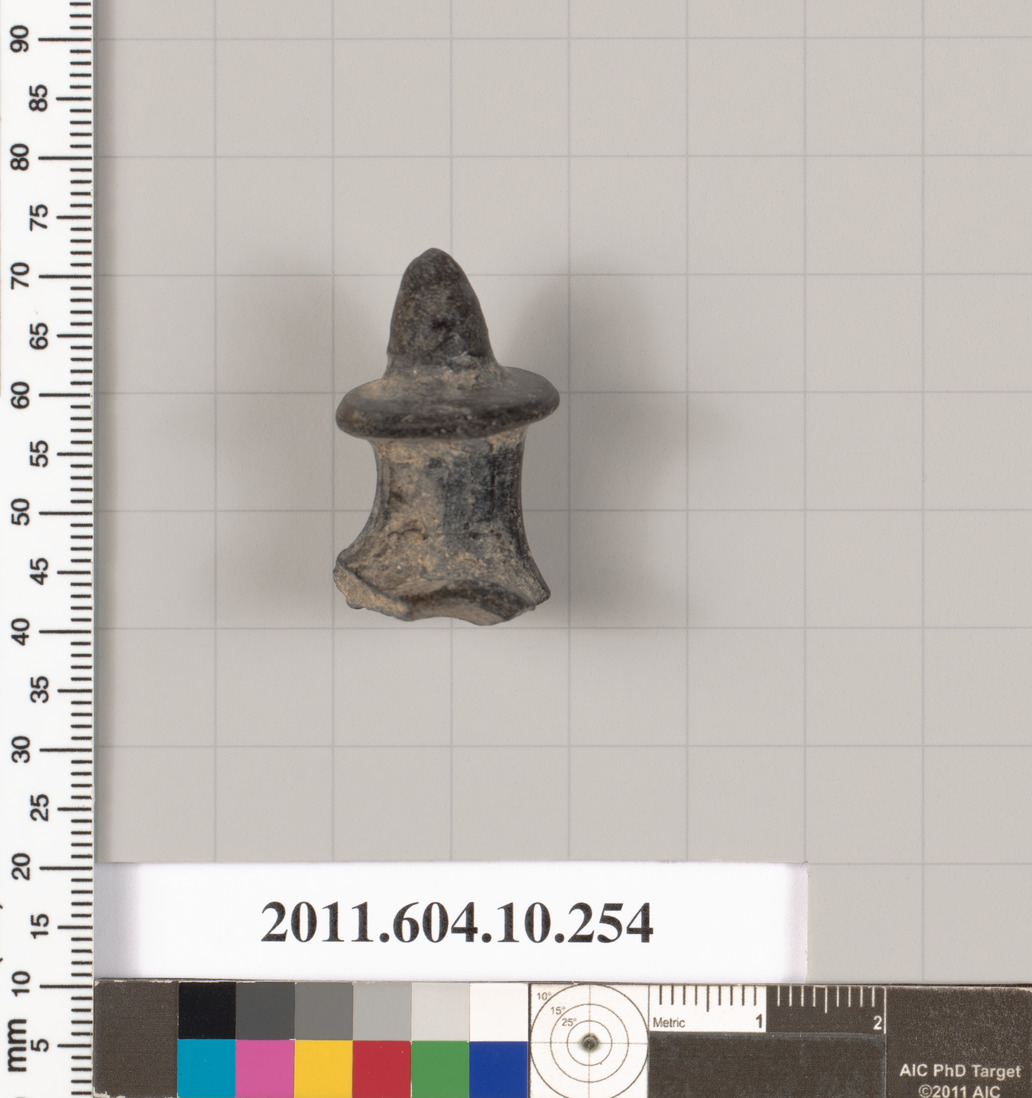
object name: kyathos fragment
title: Terracotta fragment of a kyathos (single handed cup)?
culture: etruscan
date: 600-551 BCE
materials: terracotta